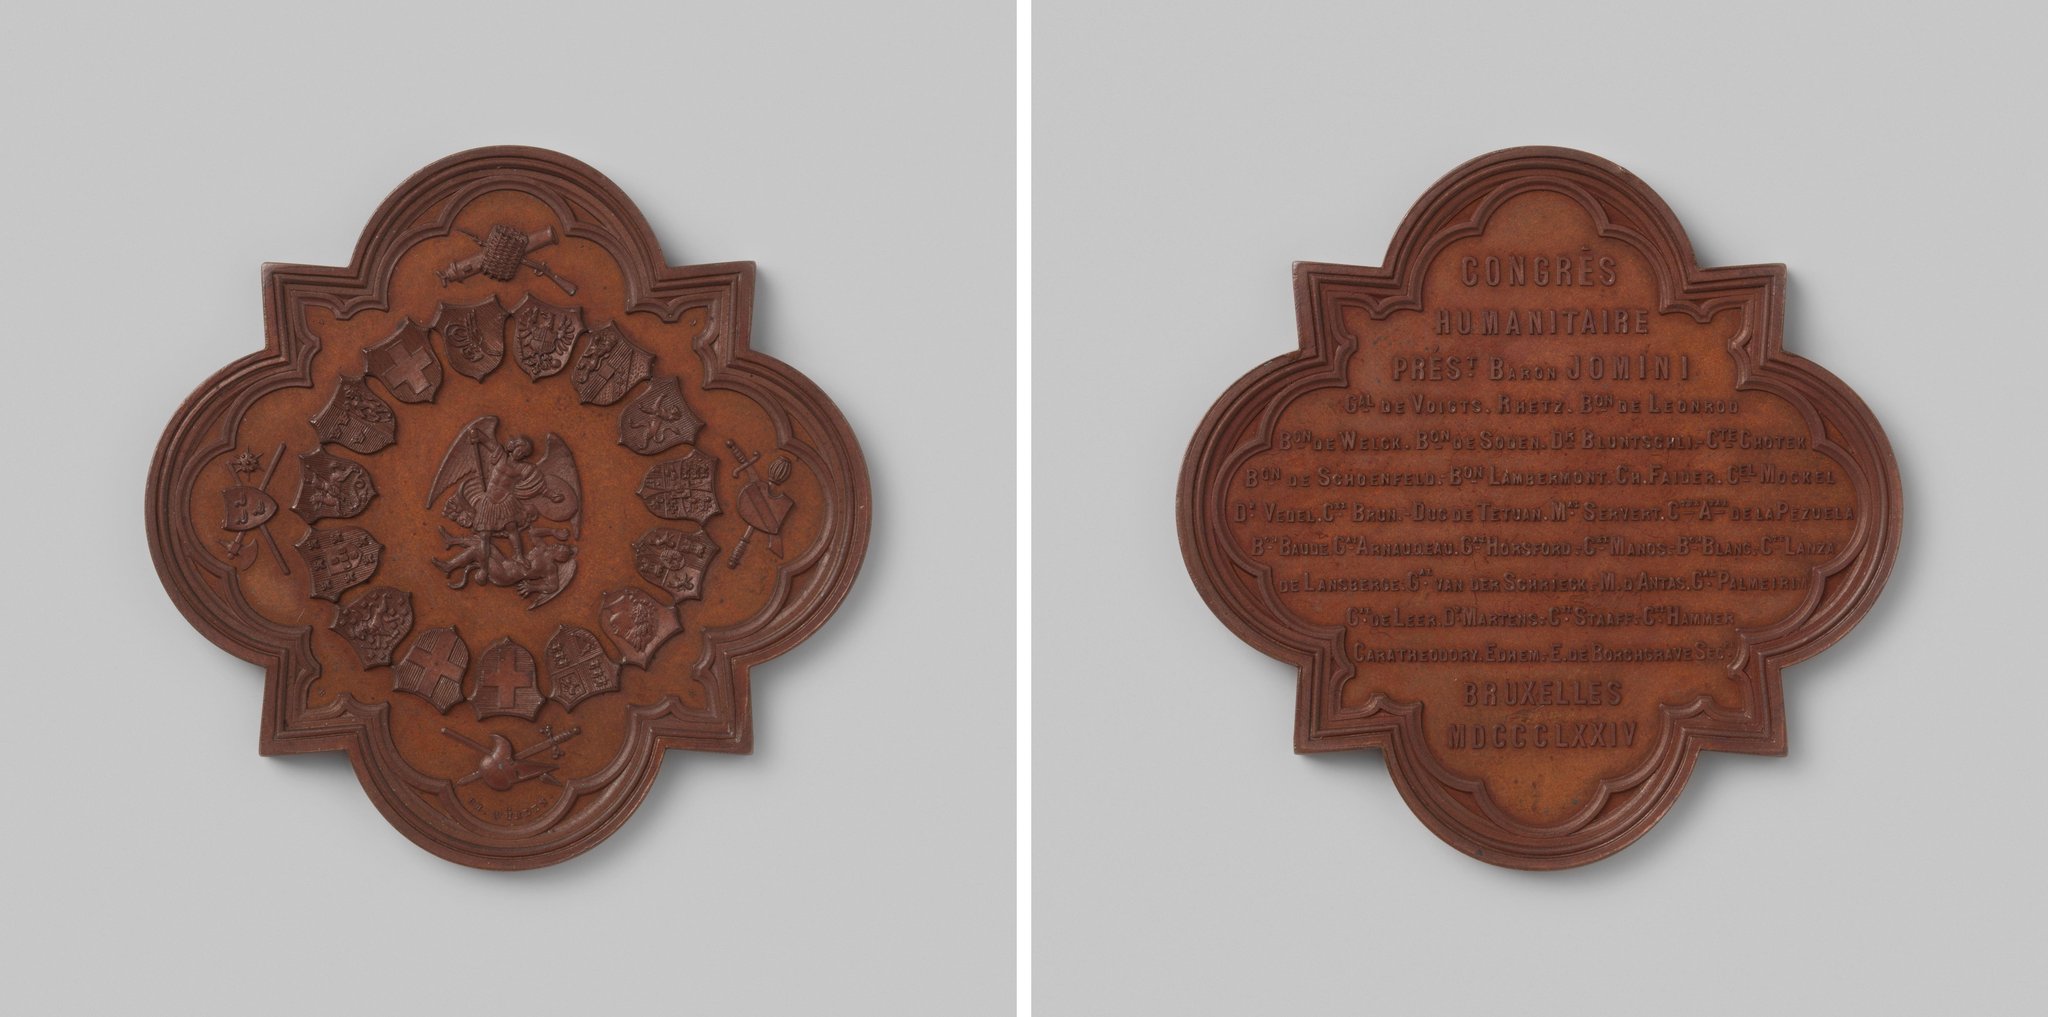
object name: history medal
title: Congres Humanitaire te Brussel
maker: henri charles wurden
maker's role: medailleur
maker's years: 1847-1908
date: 1874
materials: bronze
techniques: striking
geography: brussels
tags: brussels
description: Bronzen penning in vorm van bloem, met vier ronde bladeren, afgewisseld door vier punten. Voorzijde: engel, staat met voet op ter aarde liggende duivel, gereed om hem met zwaard te doorboren binnen rand van vijftien wapenschilden; aan alle vier de zijden daarvan versieringen met kleine wapentropheen. Keerzijde: opschrift